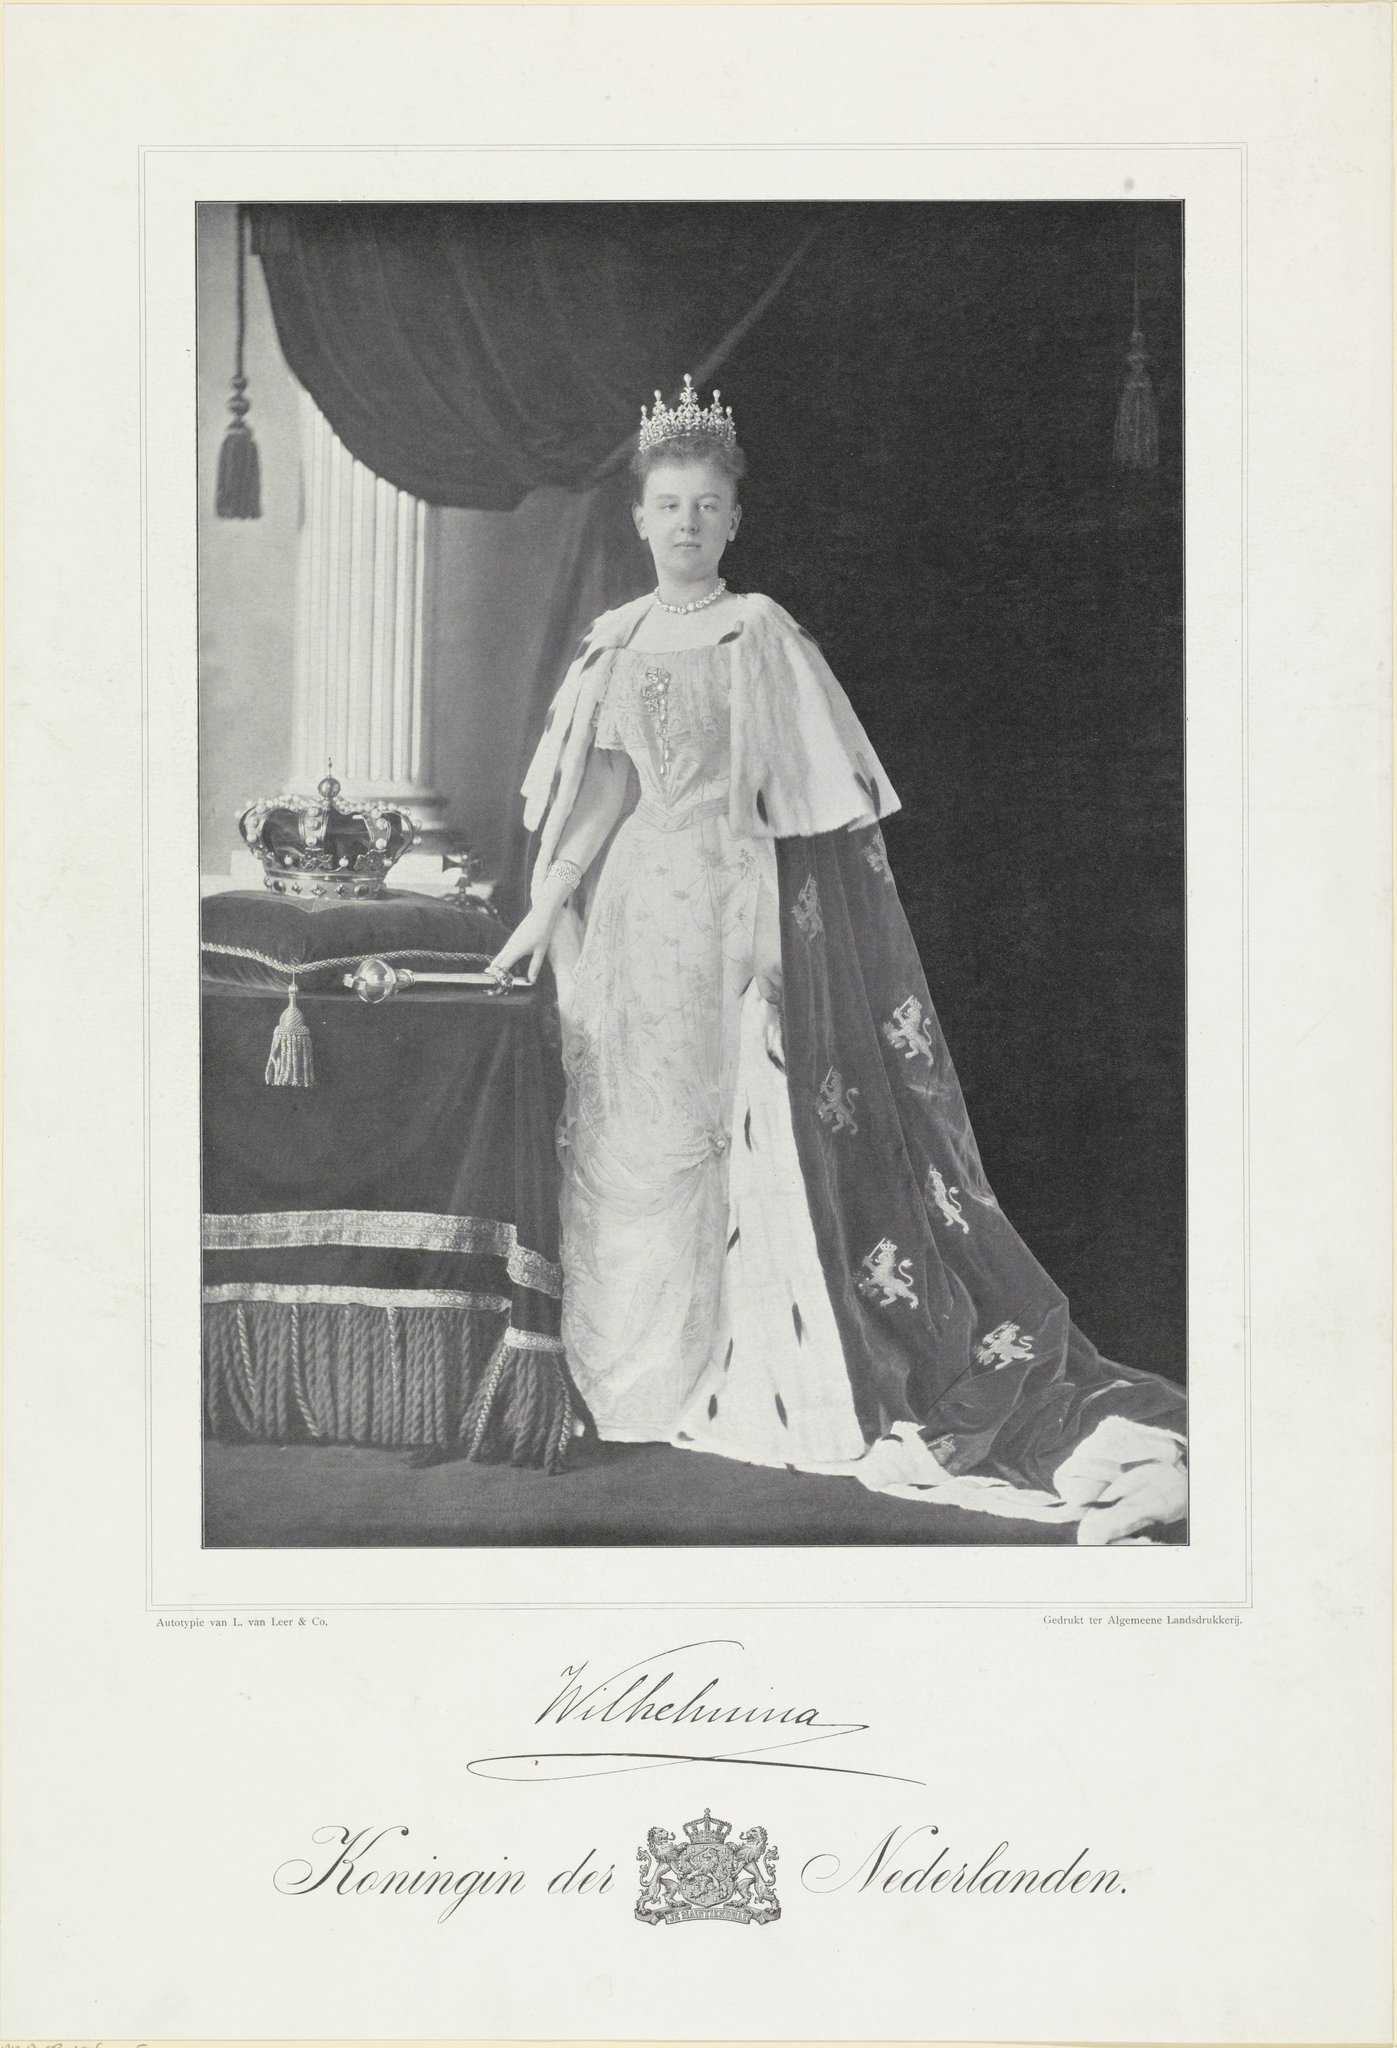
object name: photomechanical print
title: Portret van Wilhelmina, koningin der Nederlanden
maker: Anonymous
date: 1898-1900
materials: paper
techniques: autotype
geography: amsterdam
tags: the hague, print maker, wilhelmina of the netherlands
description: Portret van Wilhelmina met een hermelijnen mantel. Ze staat naast een tafel met daarop een kroon, een scepter en de rijksappel. In de ondermarge haar handtekening en haar titel.